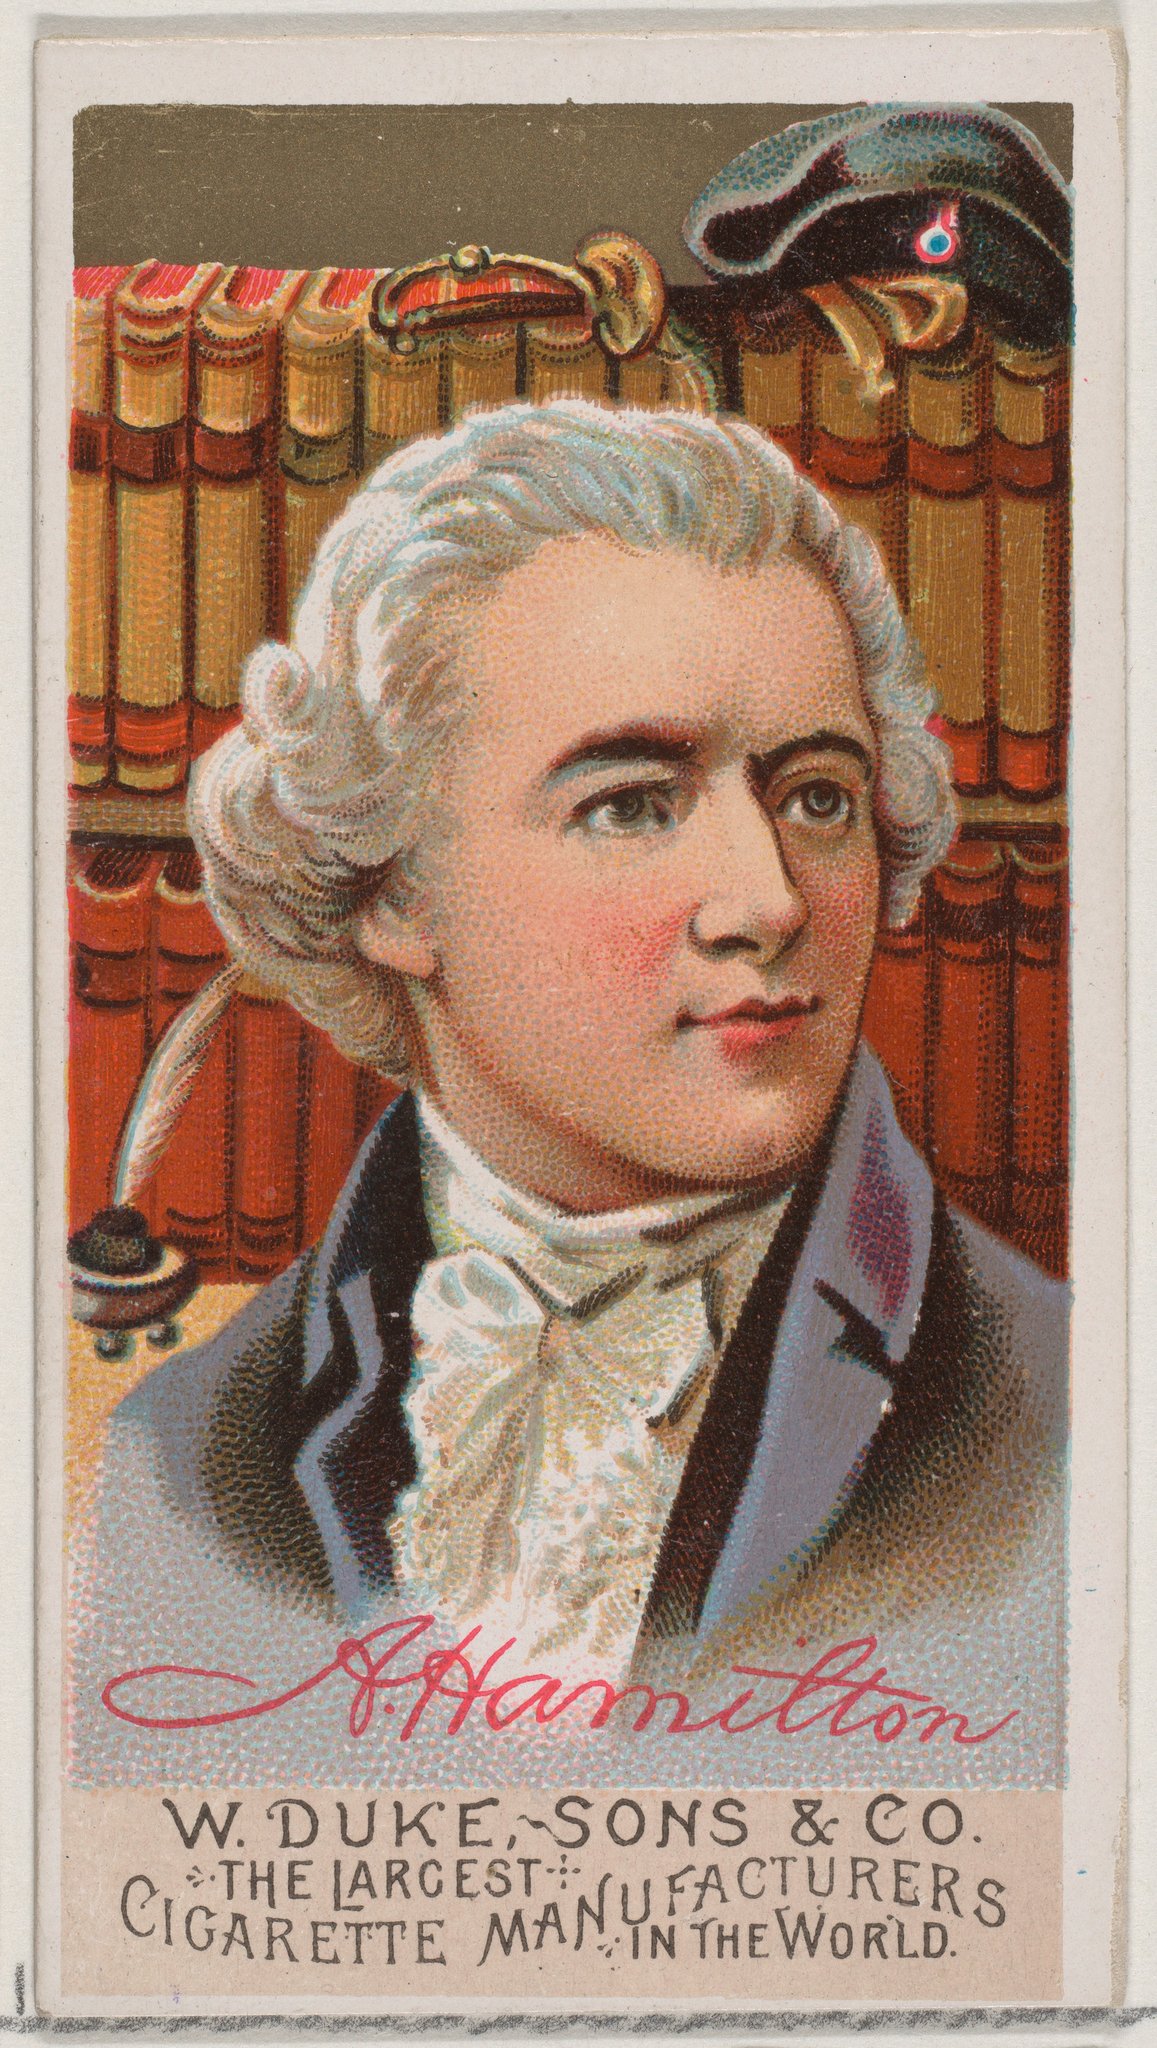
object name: print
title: Alexander Hamilton, from the series Great Americans (N76) for Duke brand cigarettes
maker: w. duke, sons & co.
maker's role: publisher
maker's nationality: american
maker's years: 1870-1920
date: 1888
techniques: color lithograph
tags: men